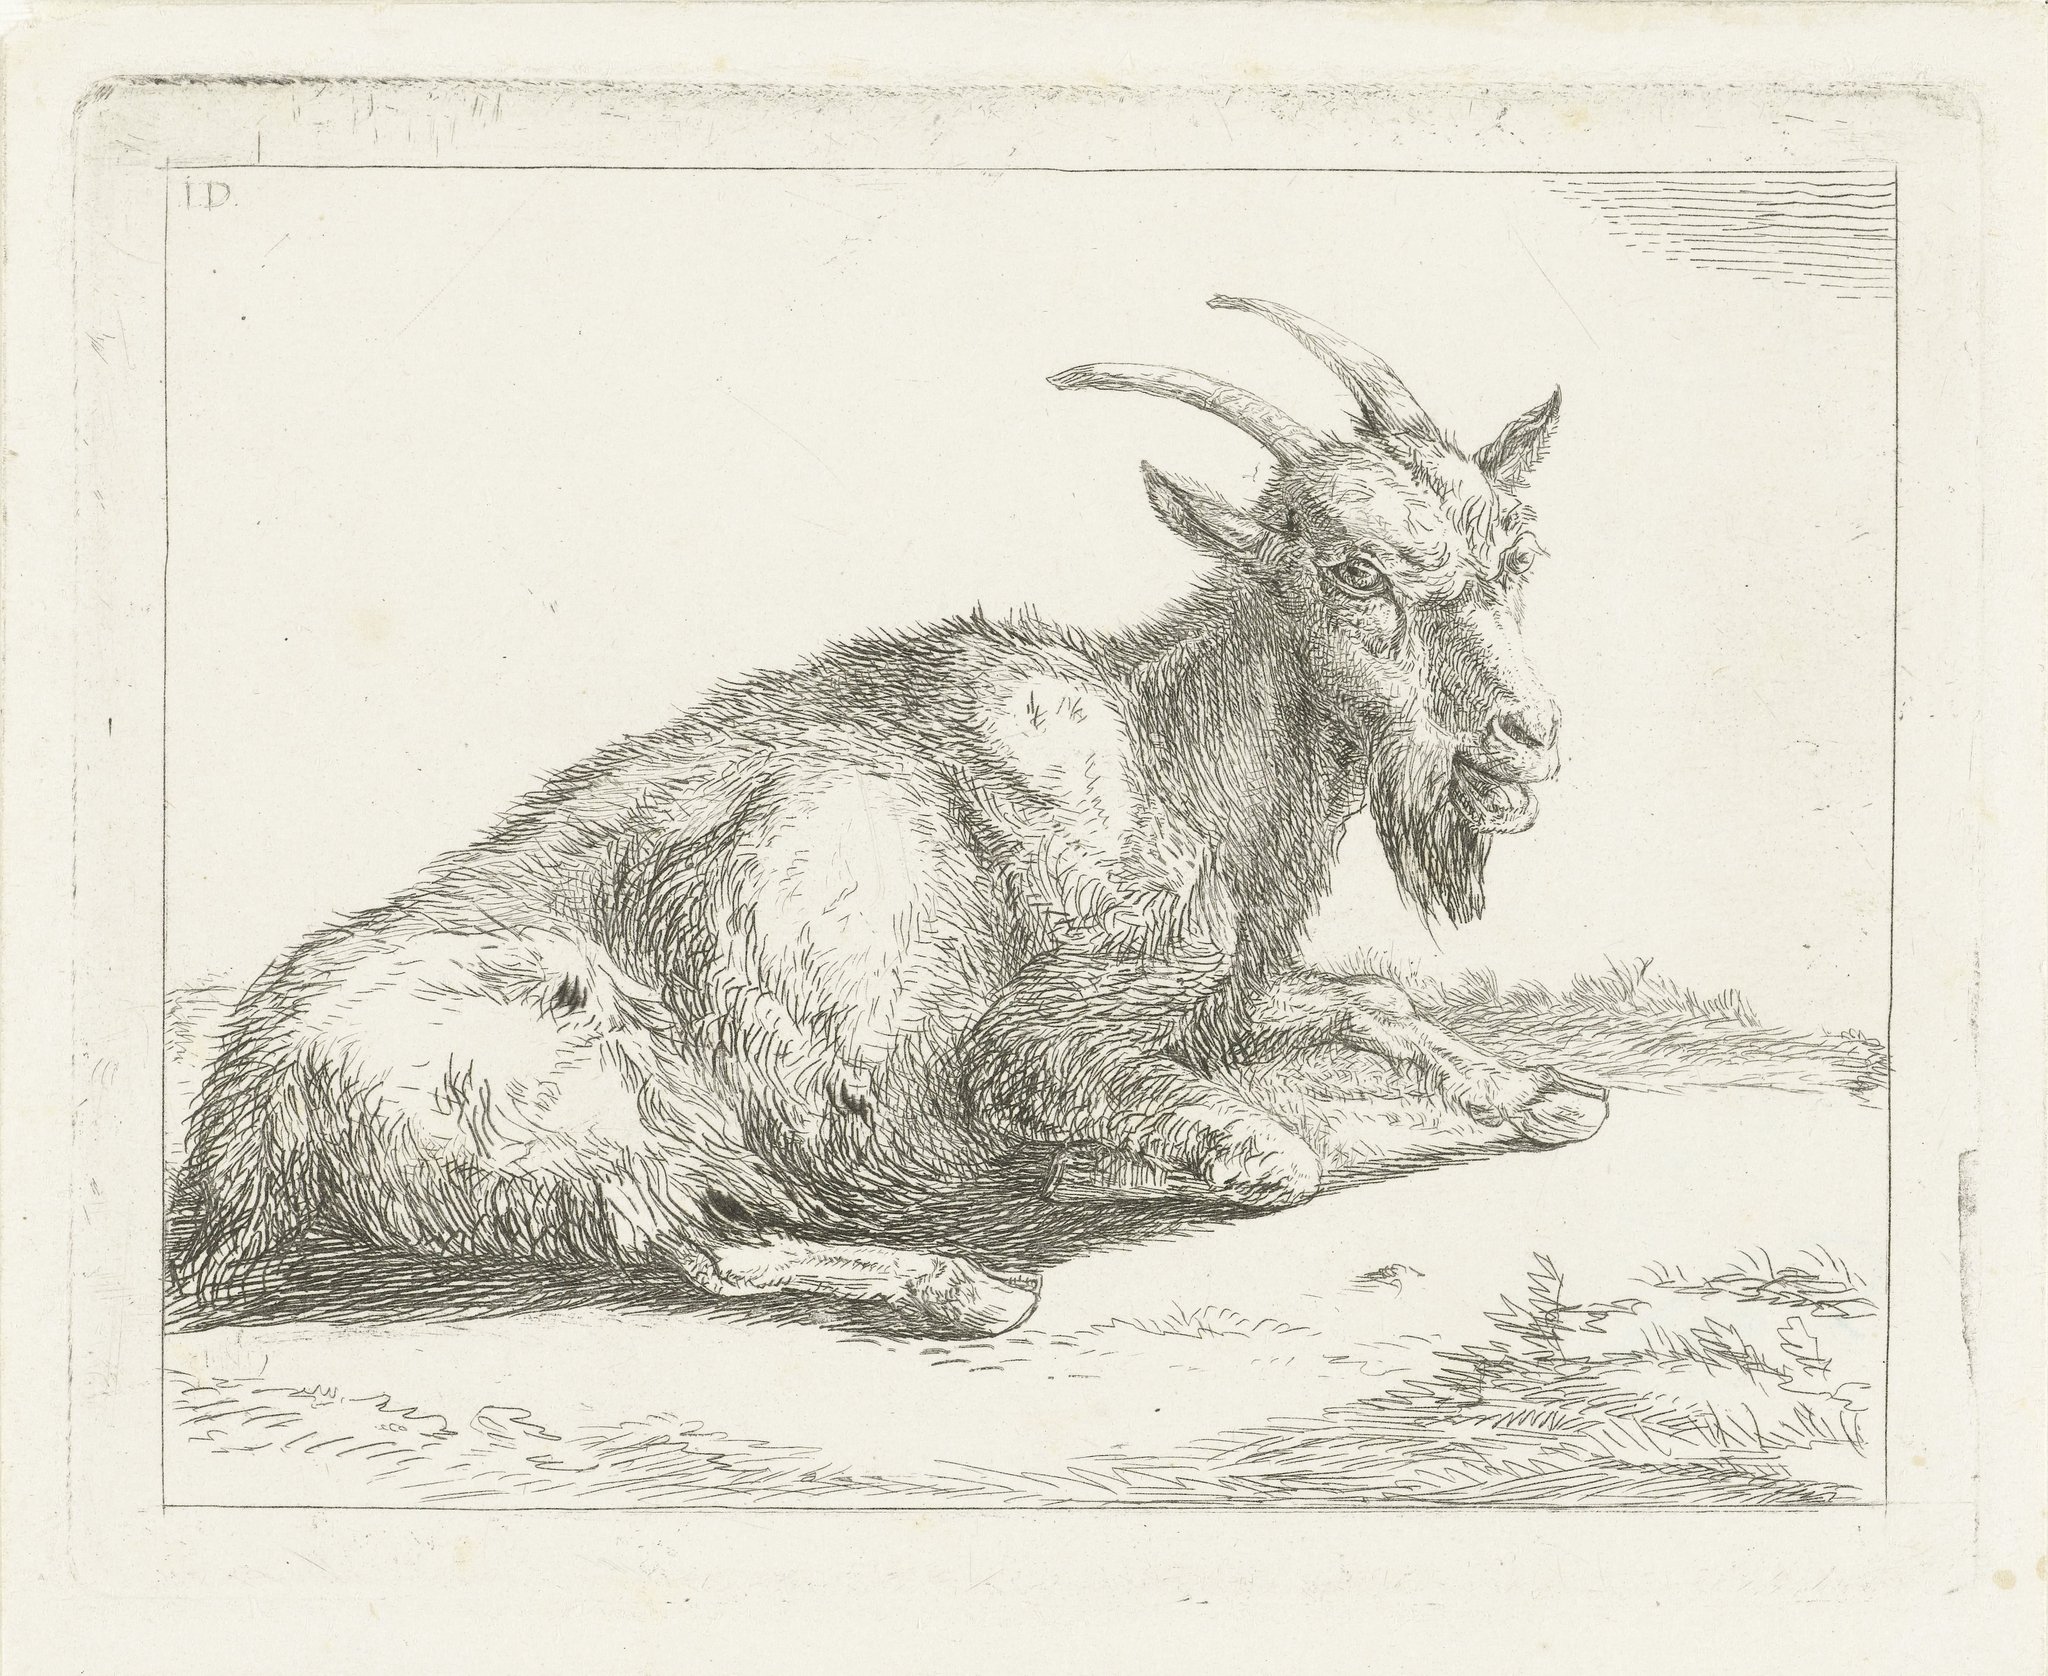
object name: print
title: Geit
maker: jan dasveldt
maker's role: draughtsman, print maker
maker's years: 1770-1855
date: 1780-1855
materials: paper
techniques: etching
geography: amsterdam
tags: goat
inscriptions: collector's mark: Lugt 2228